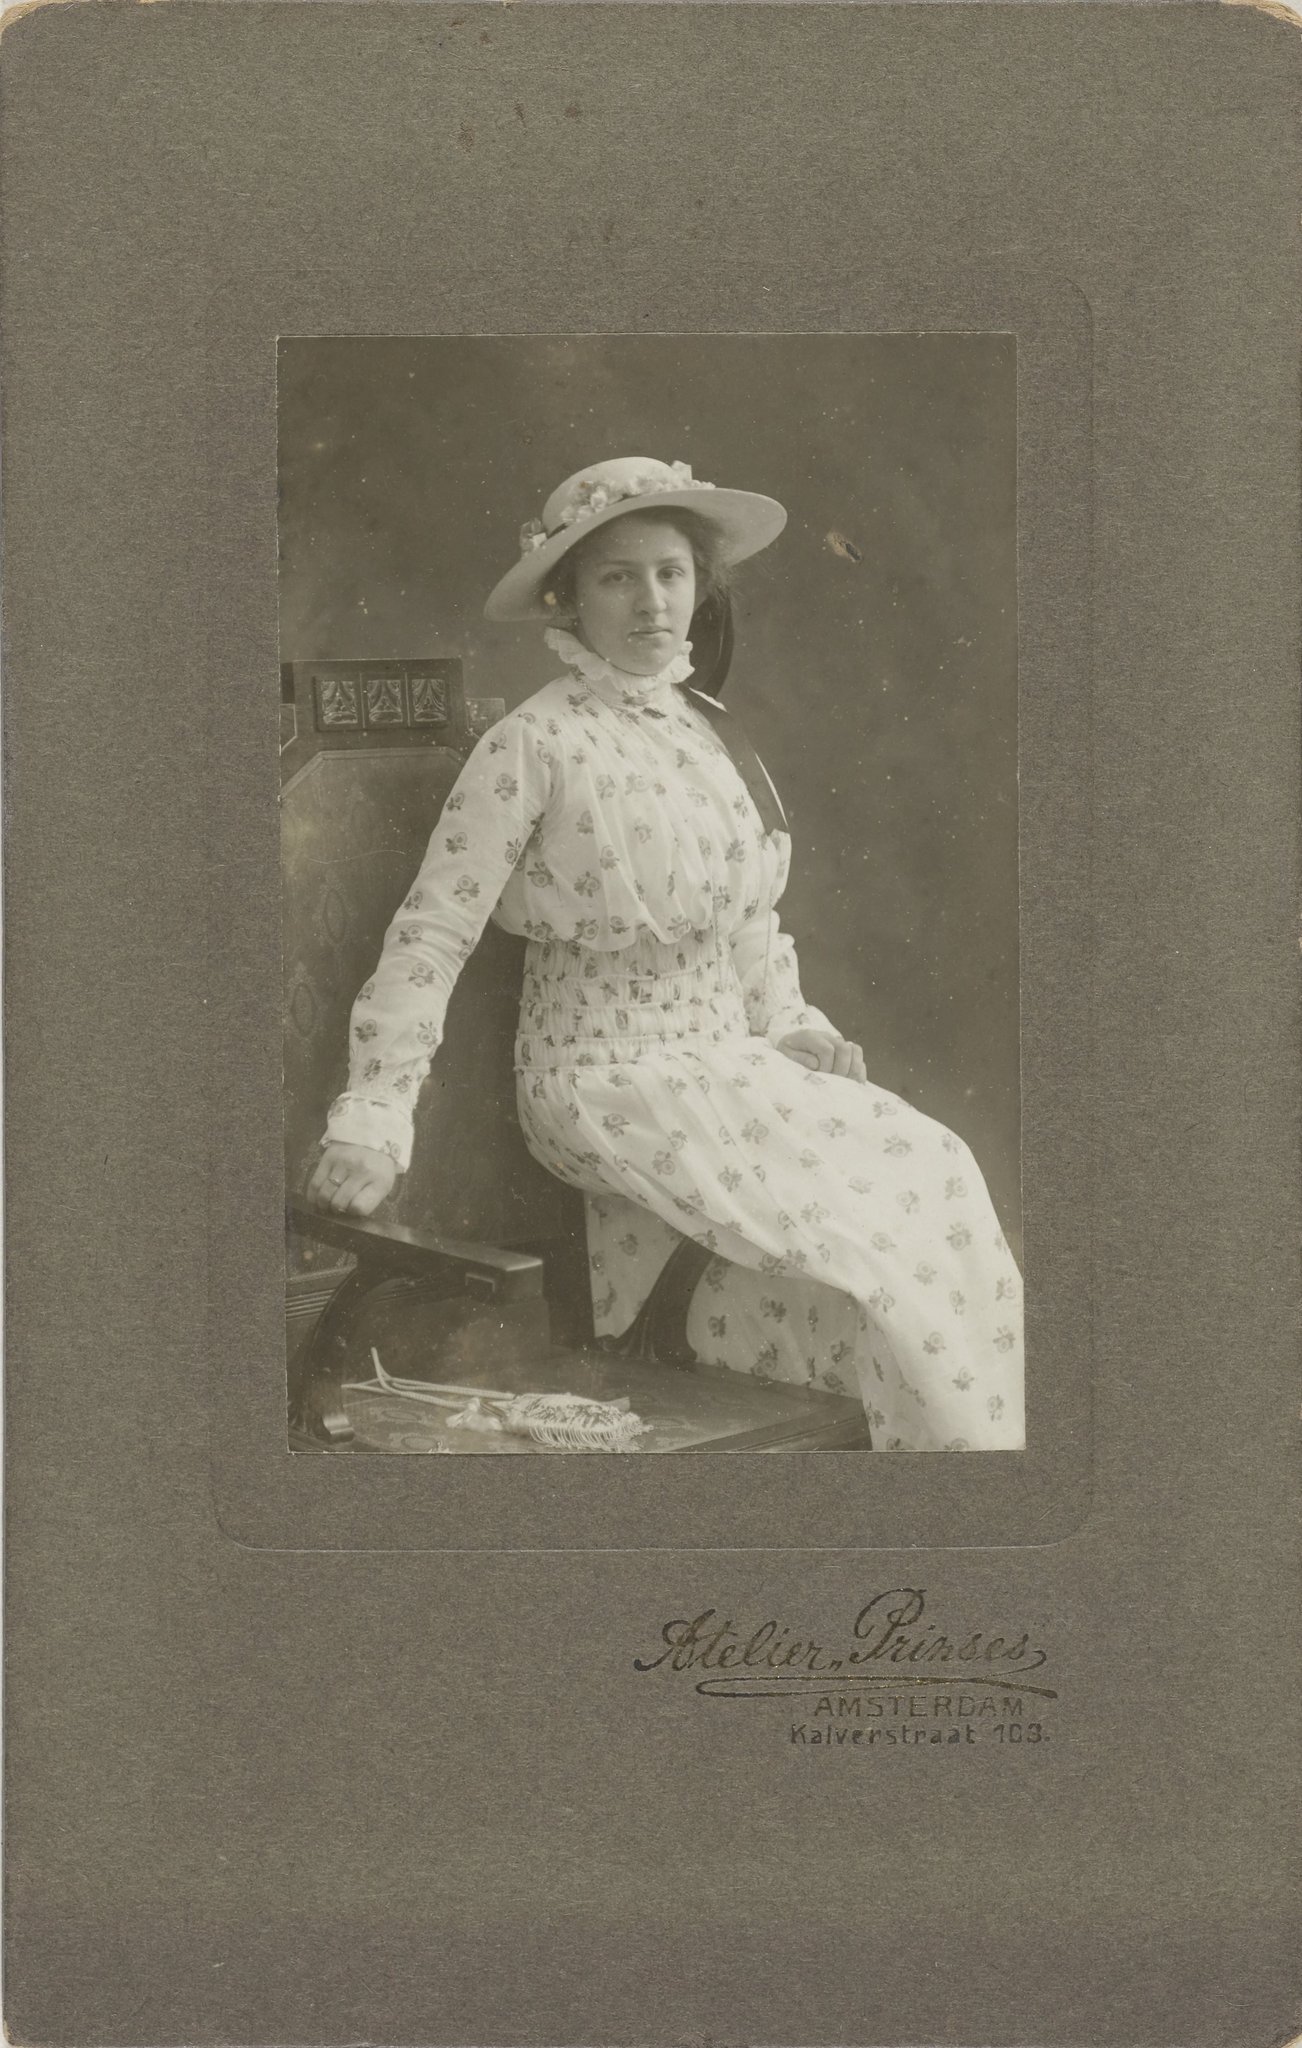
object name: photograph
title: Studioportret van dame zittend op stoelleuning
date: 1890-1920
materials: cardboard, photographic support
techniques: gelatin silver print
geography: amsterdam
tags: amsterdam